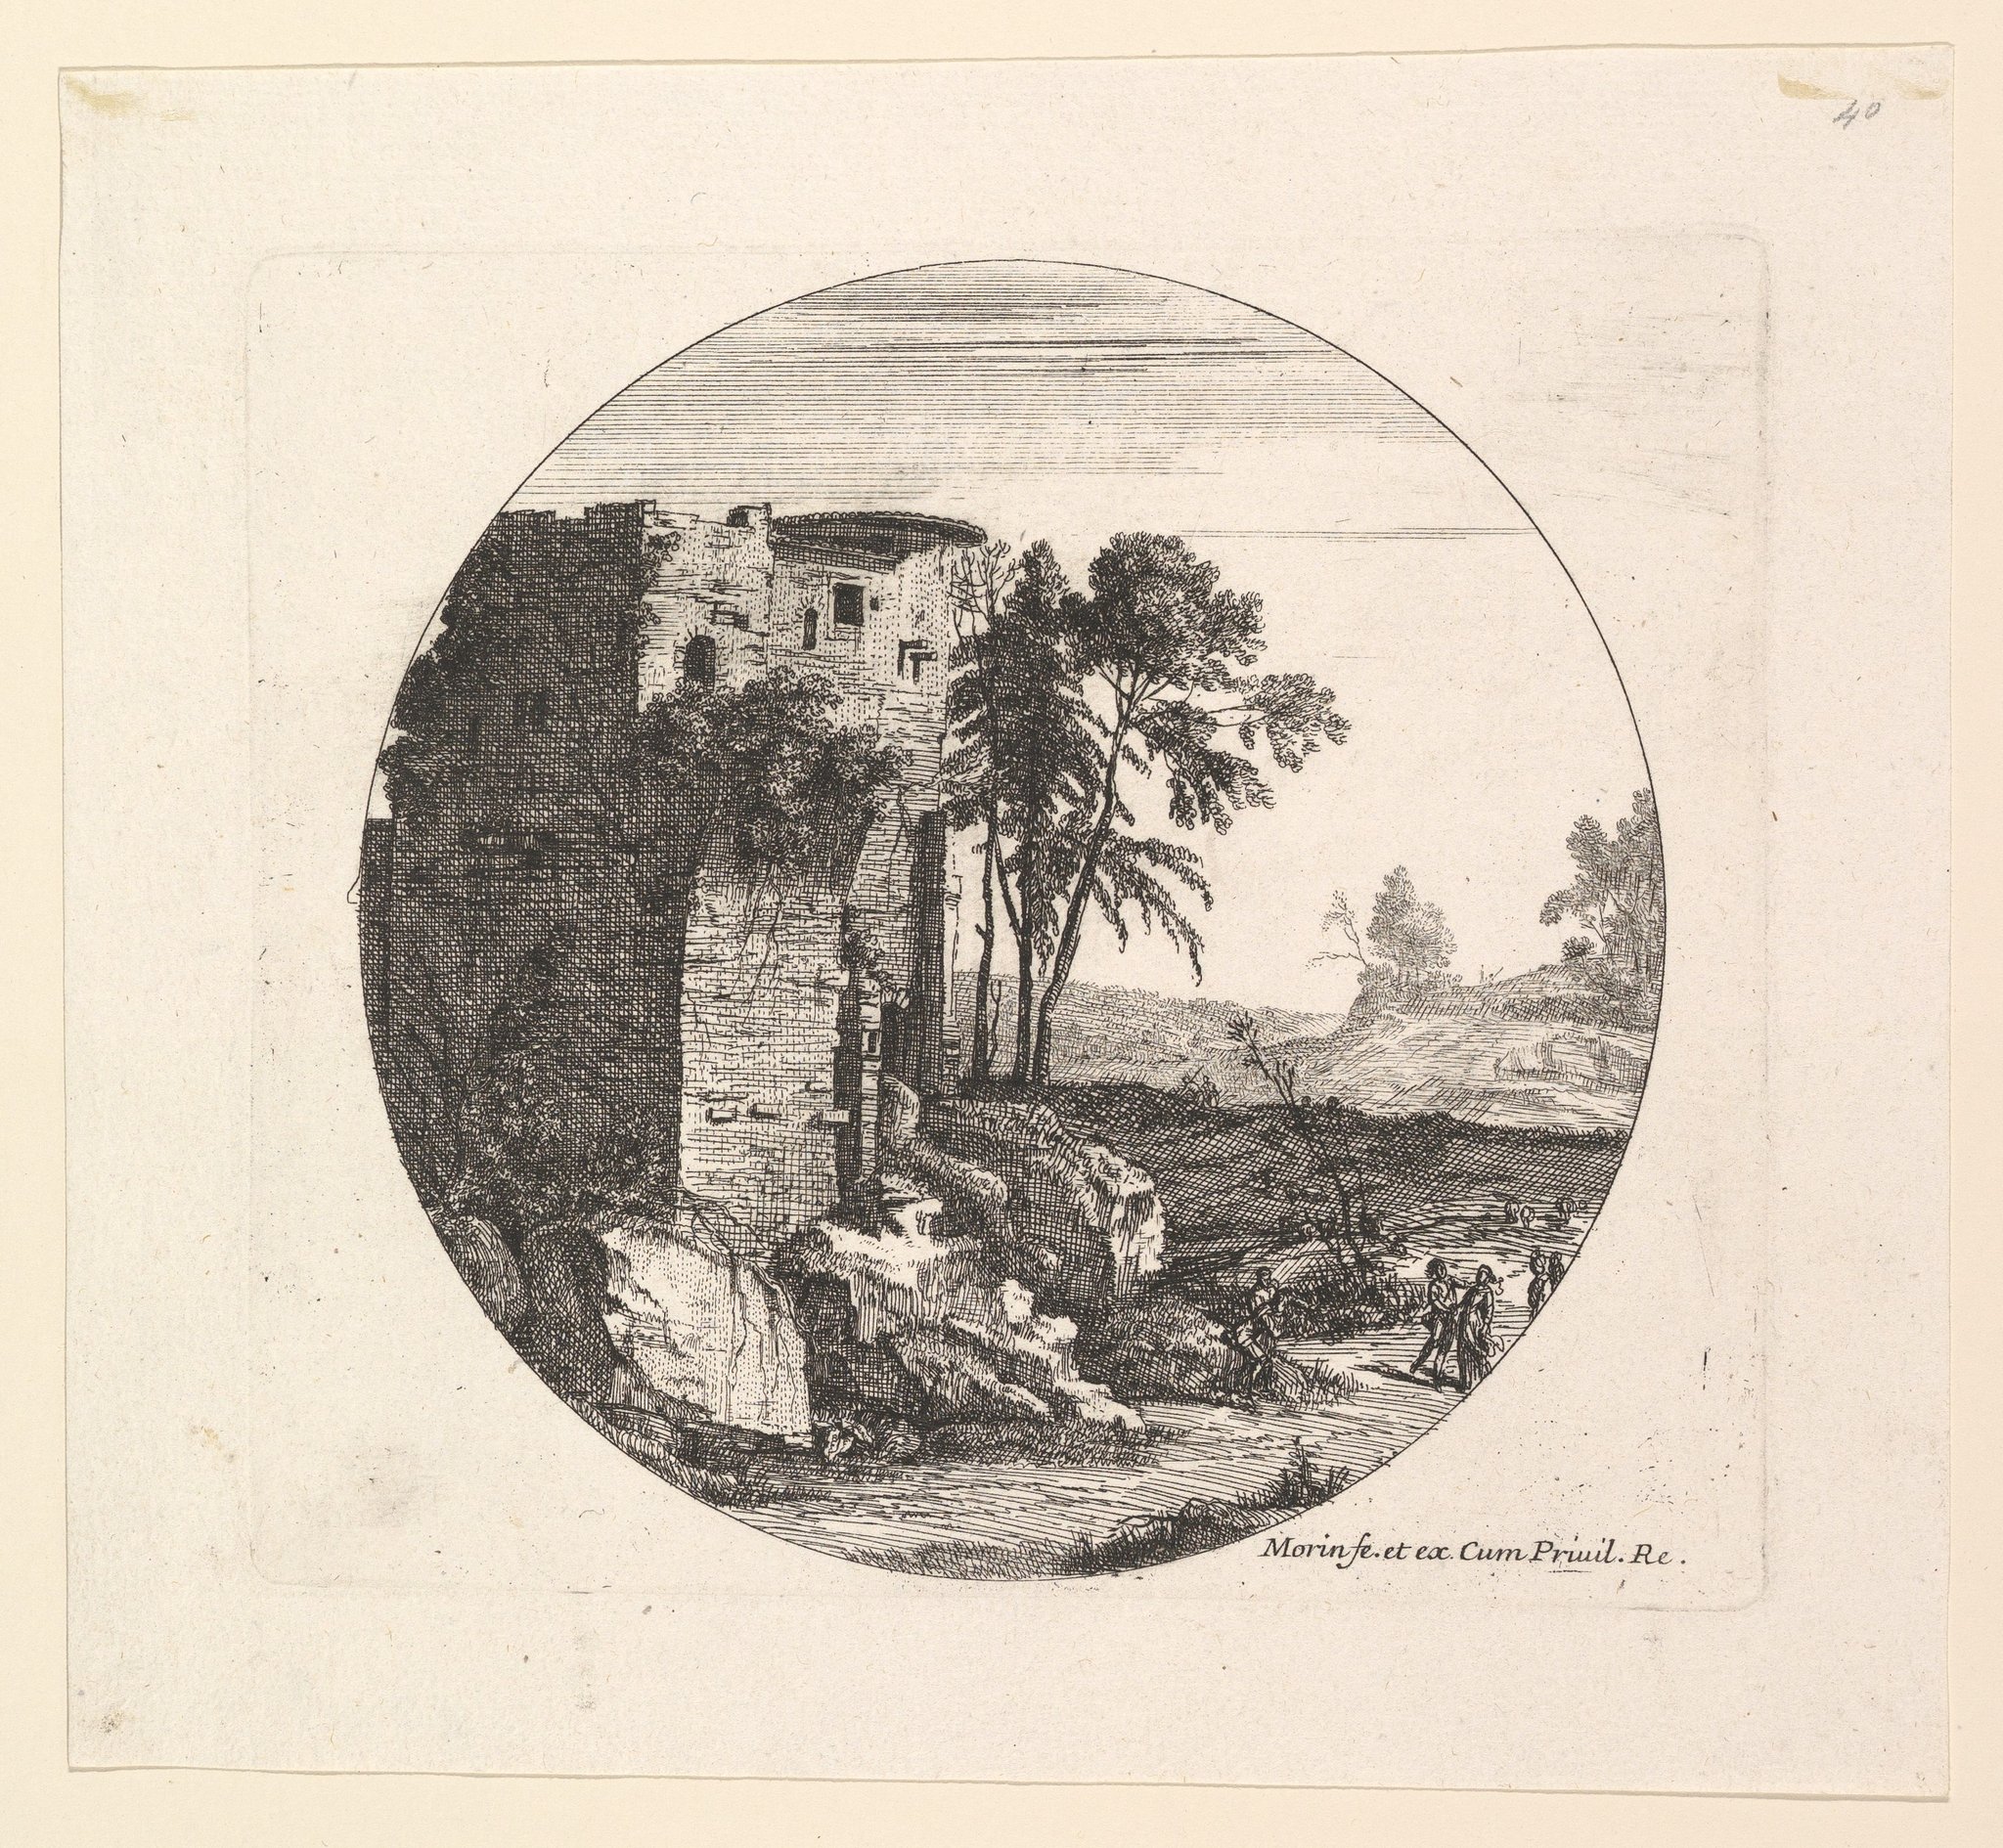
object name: print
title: Les Ruines a gauche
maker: jean morin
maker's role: artist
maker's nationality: french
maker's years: 1605-1650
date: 1605-1650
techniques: etching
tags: ruins,trees